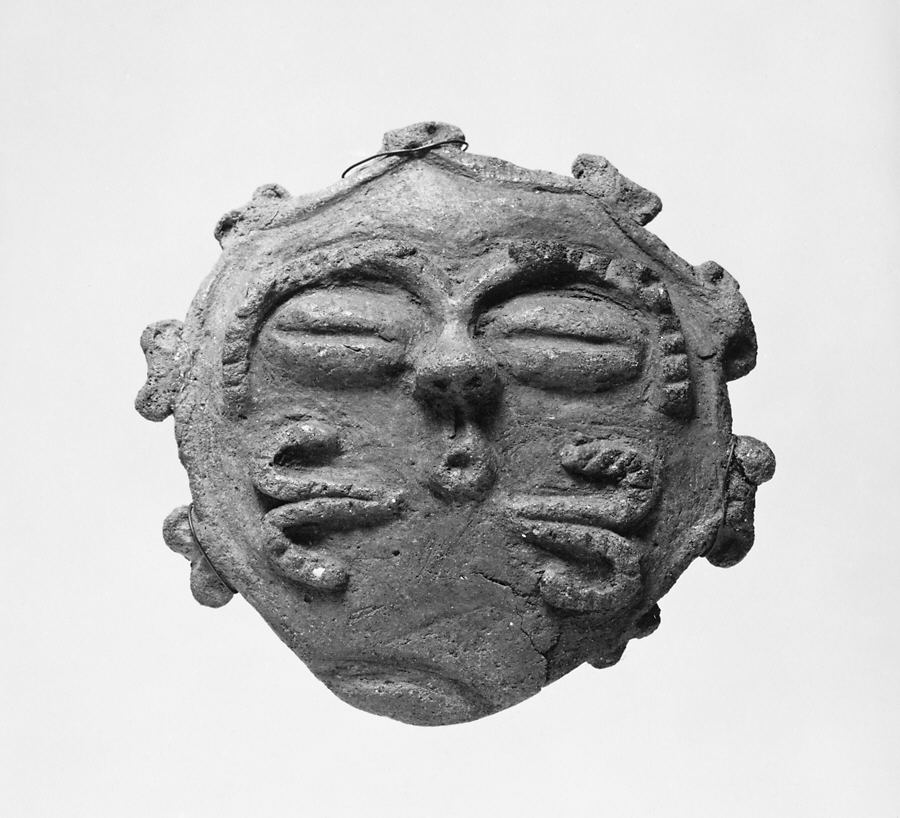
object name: plaque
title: Plaque in the Shape of a Human Face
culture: japanese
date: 1000-400 BCE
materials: earthenware, pigment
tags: faces